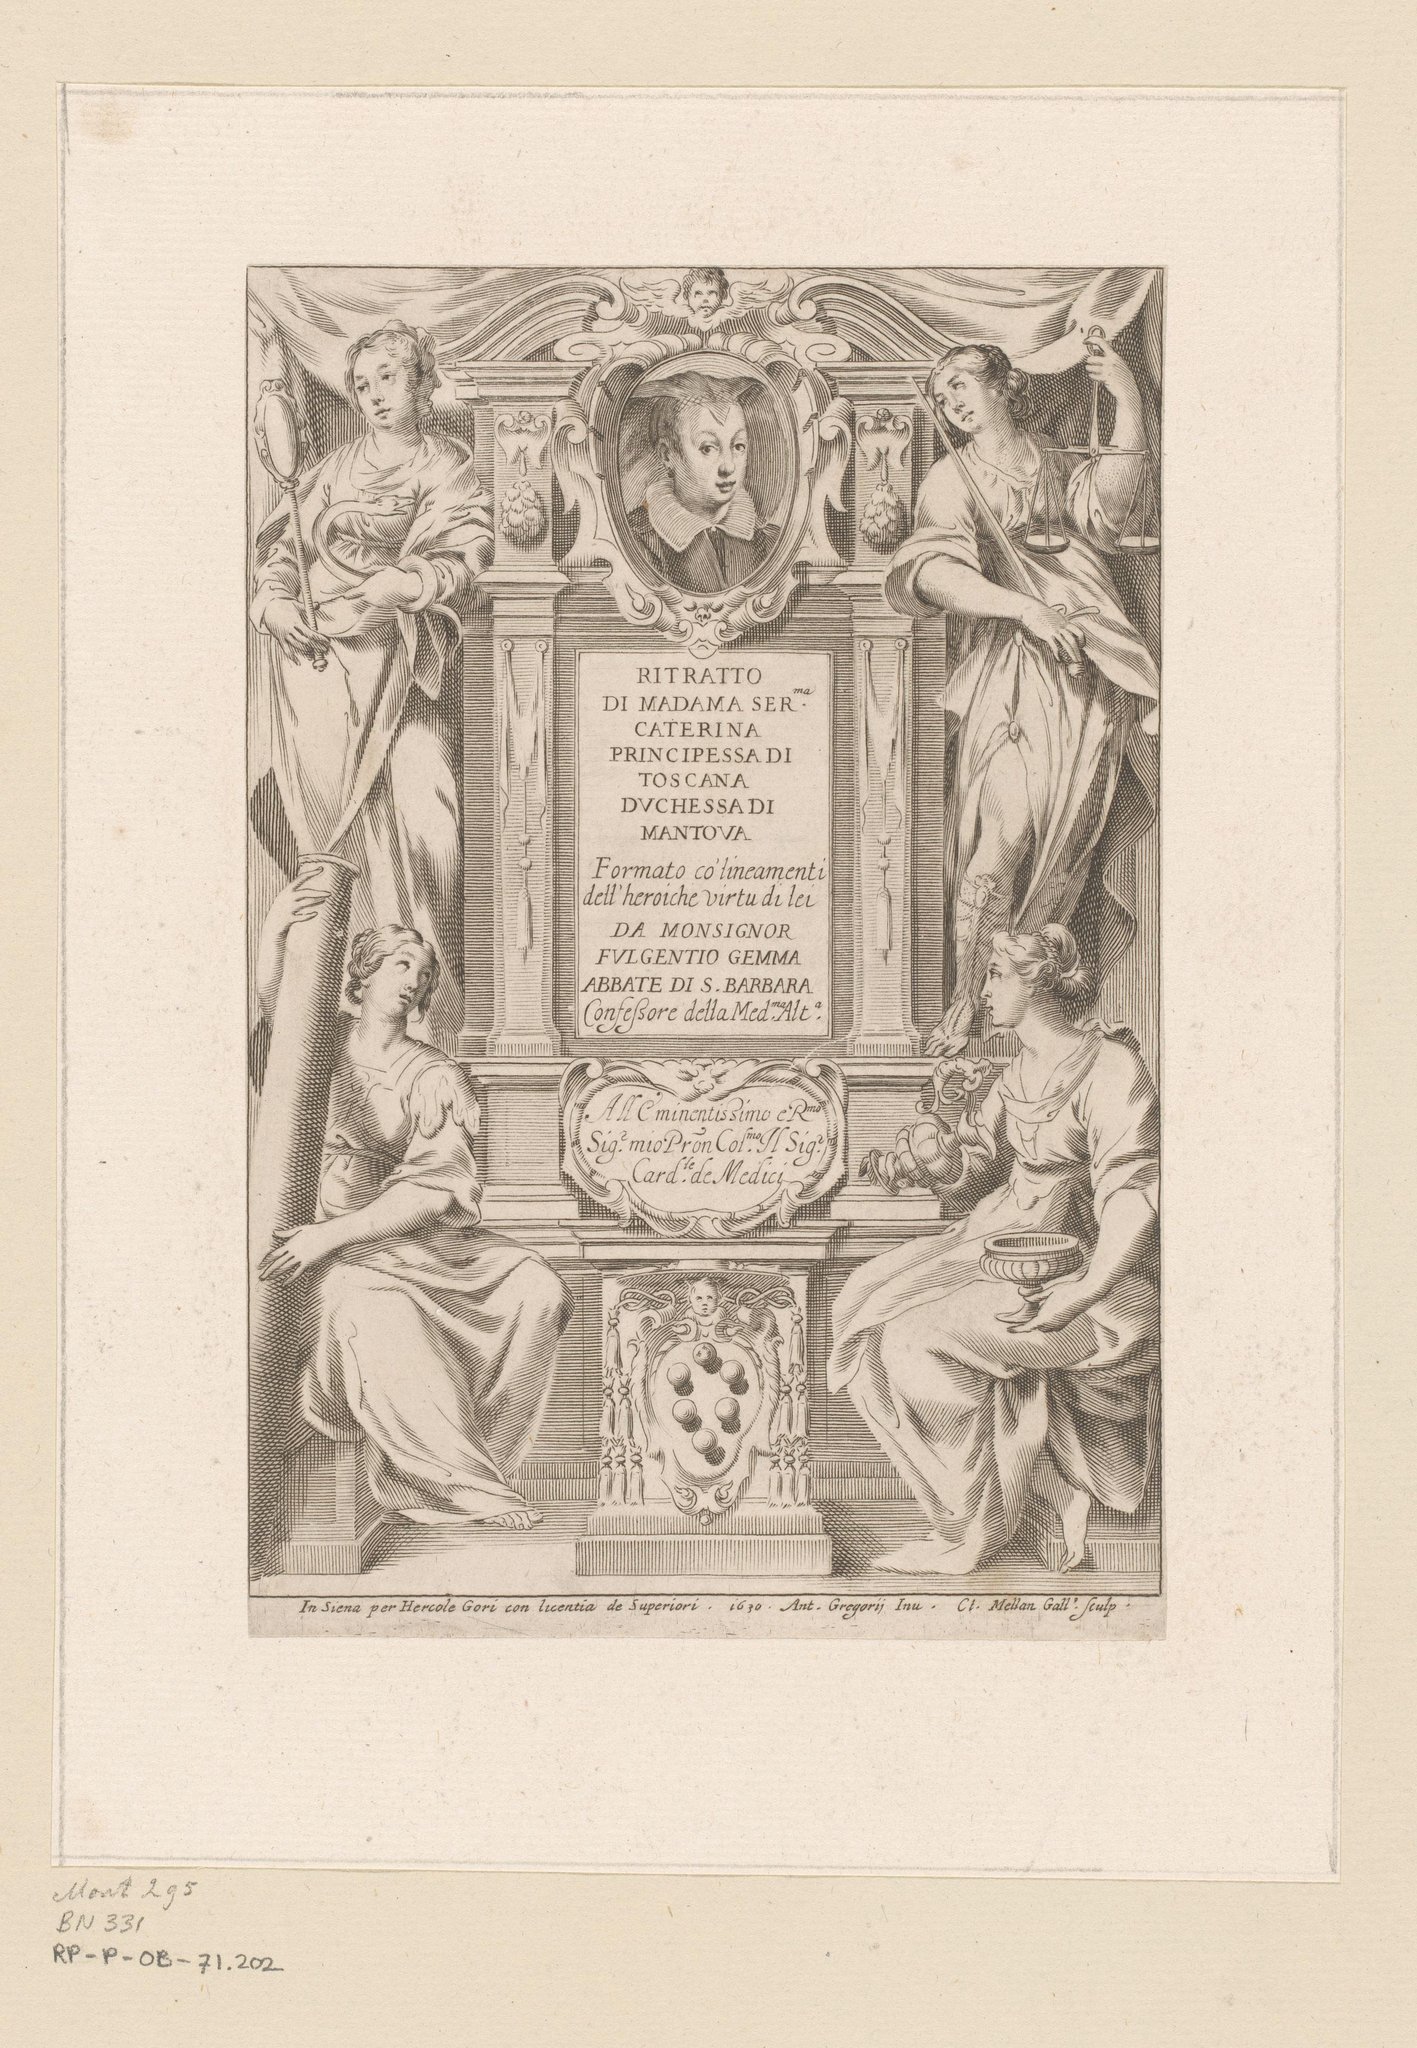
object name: print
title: Titelpagina voor: Fulgentio Gemma, Ritratto di Madama Serenissima Caterina principessa di Toscane, 1630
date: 1630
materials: paper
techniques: engraving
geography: italy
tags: historical persons, the four cardinal virtues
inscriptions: collector's mark: Lugt 240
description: Titelpagina voor: Gemma, Fulgentio. Ritratto di Madama Serenissima Caterina principessa di Toscane. Siena: Hercole Gori, 1630.